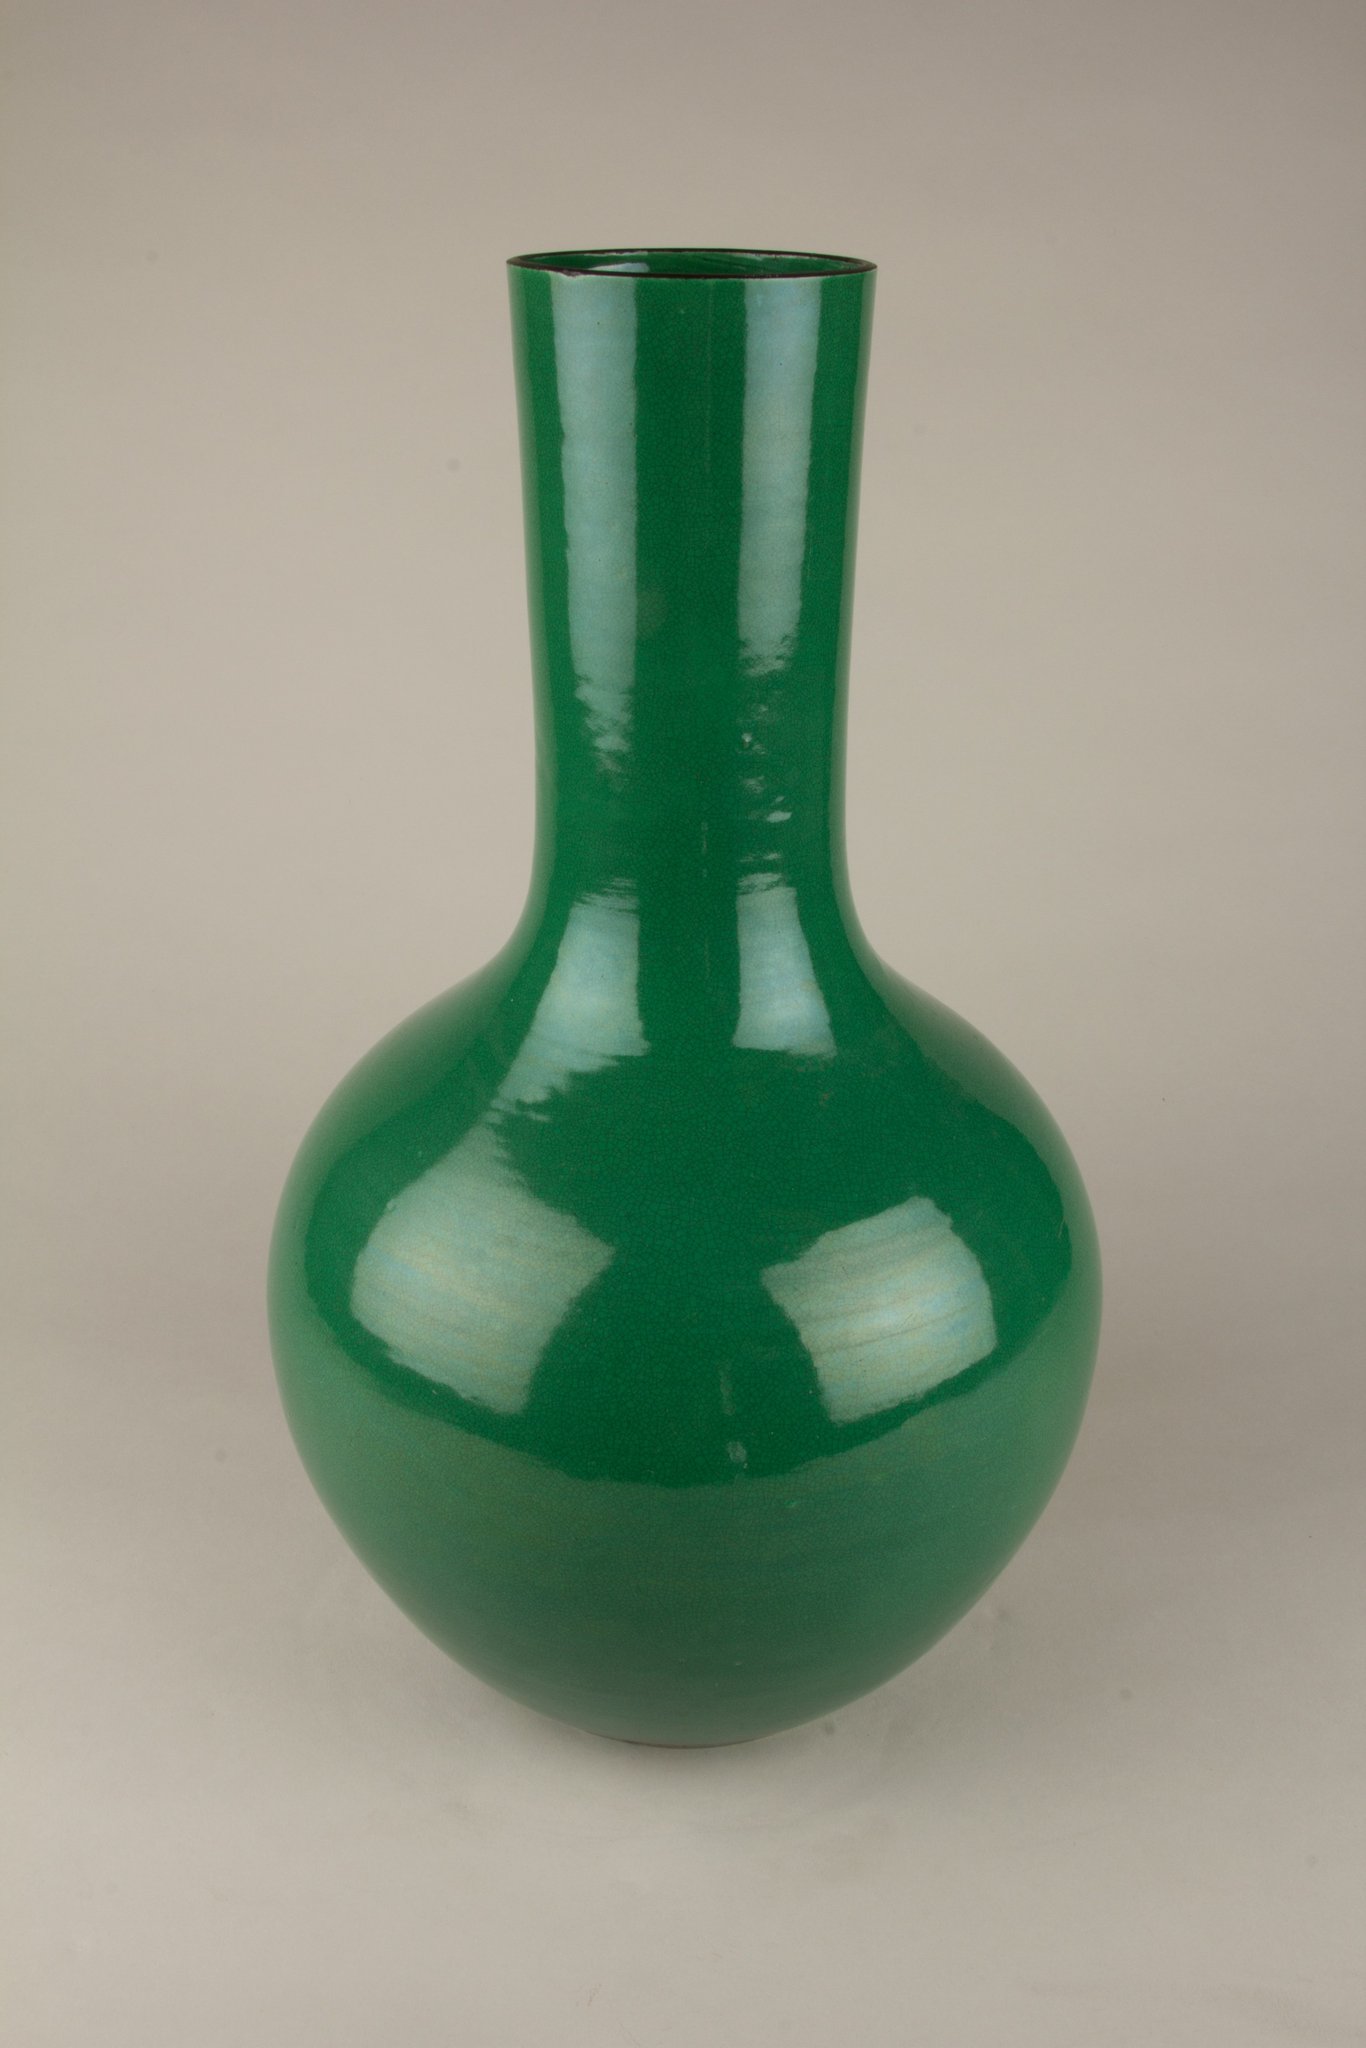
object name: vase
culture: chinese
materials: glaze, porcelain